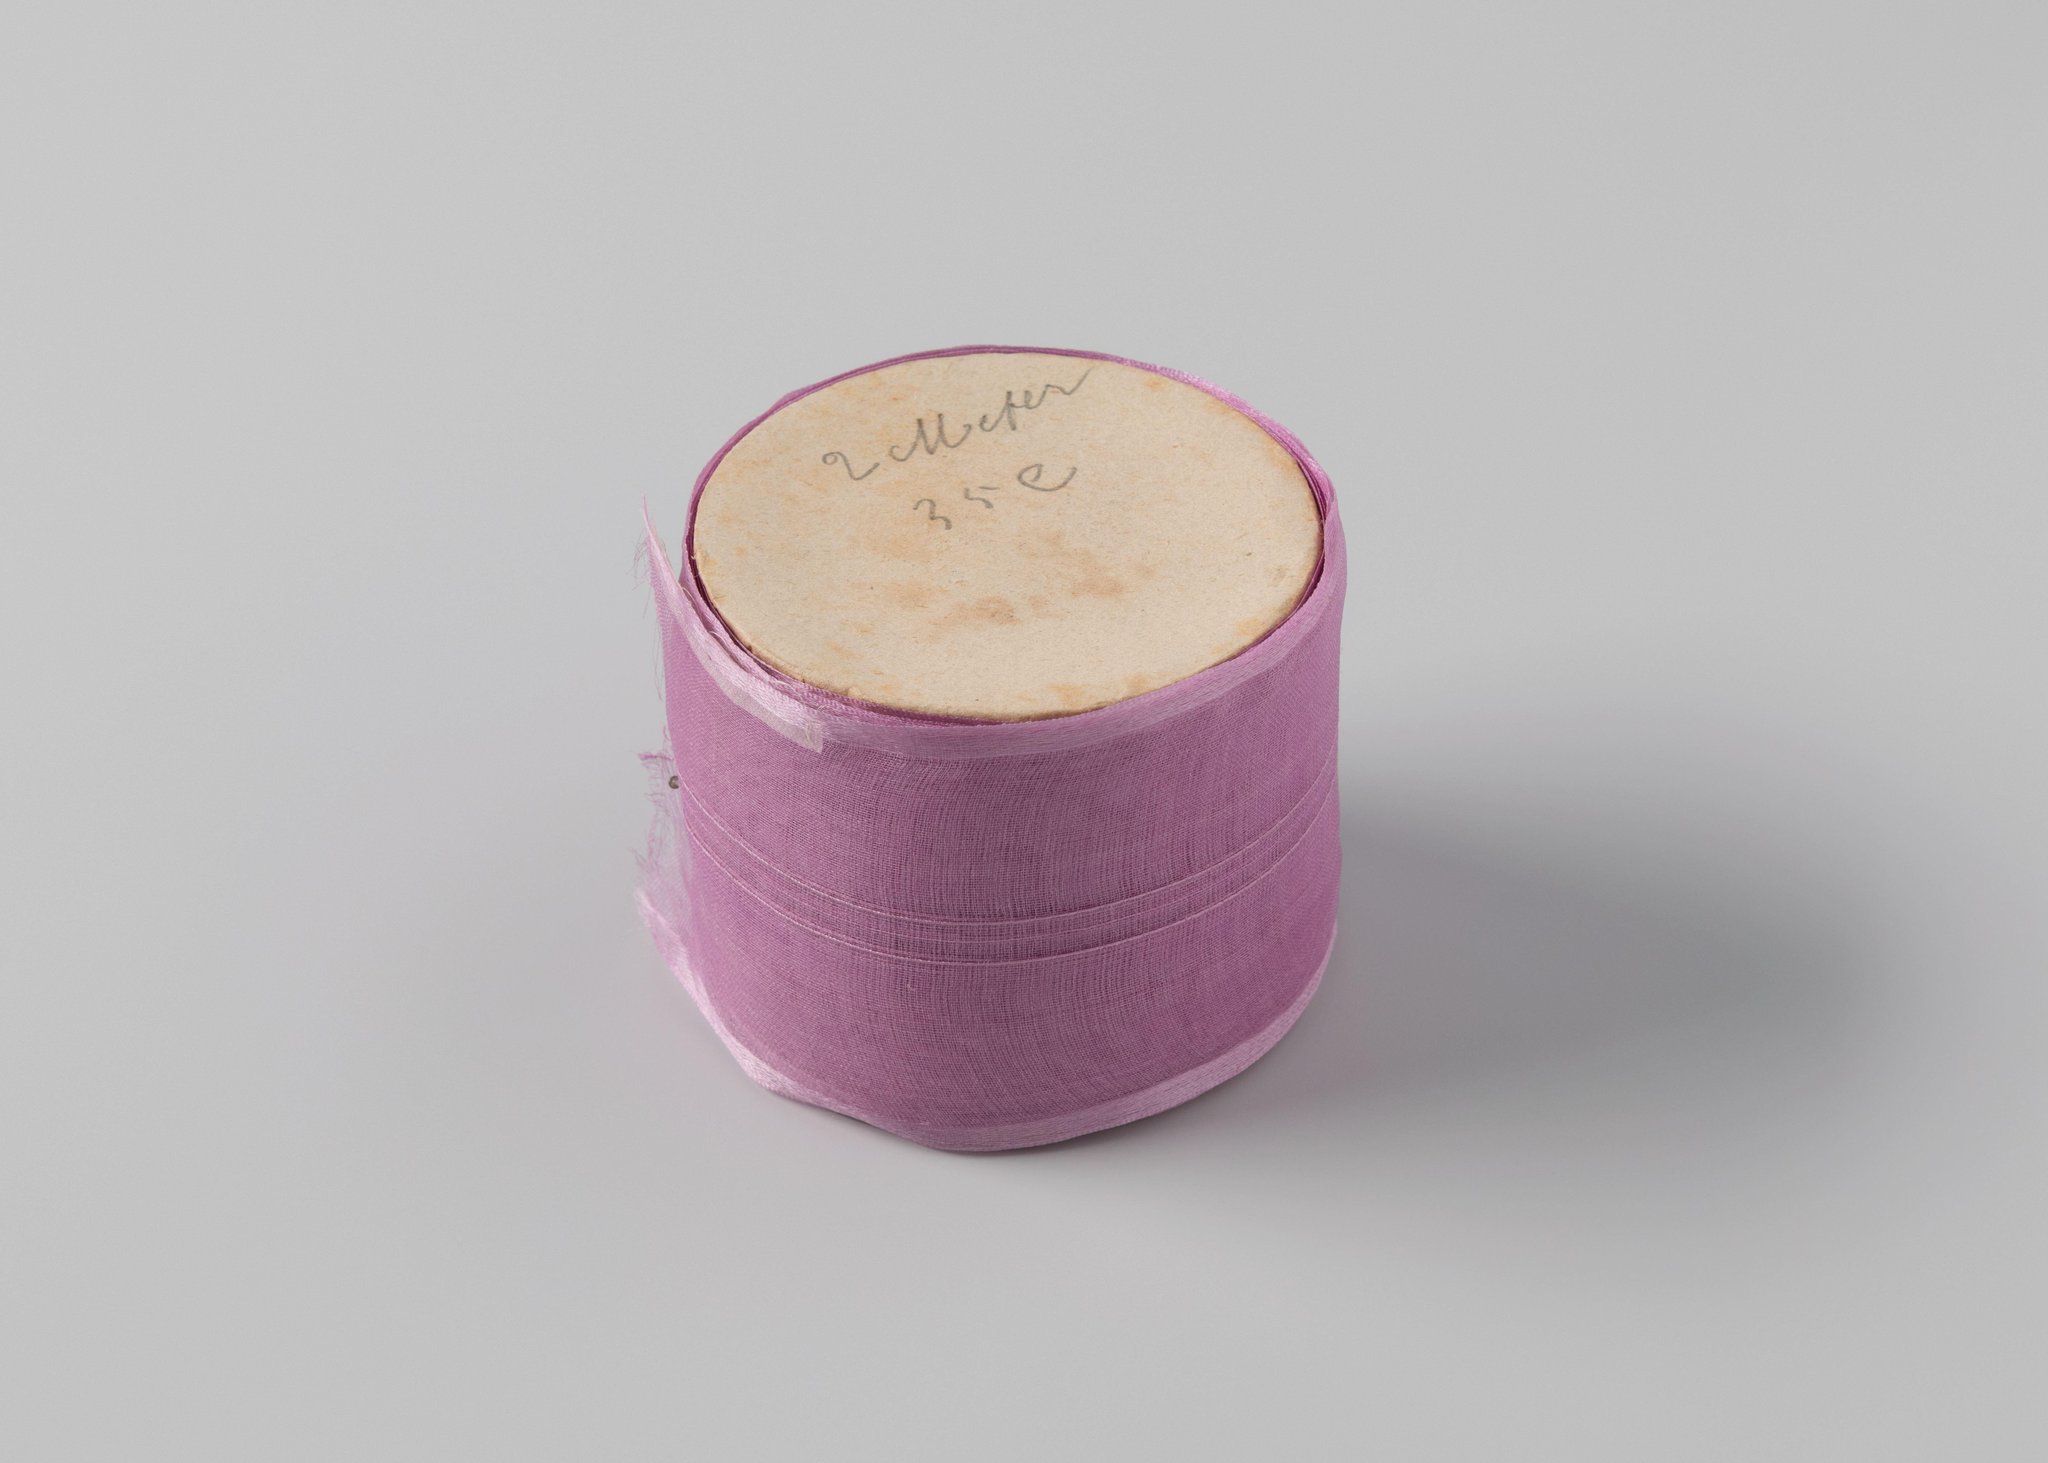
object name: ribbon material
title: Lint van lila gaas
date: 1900-1915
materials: textile, silk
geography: nijmegen